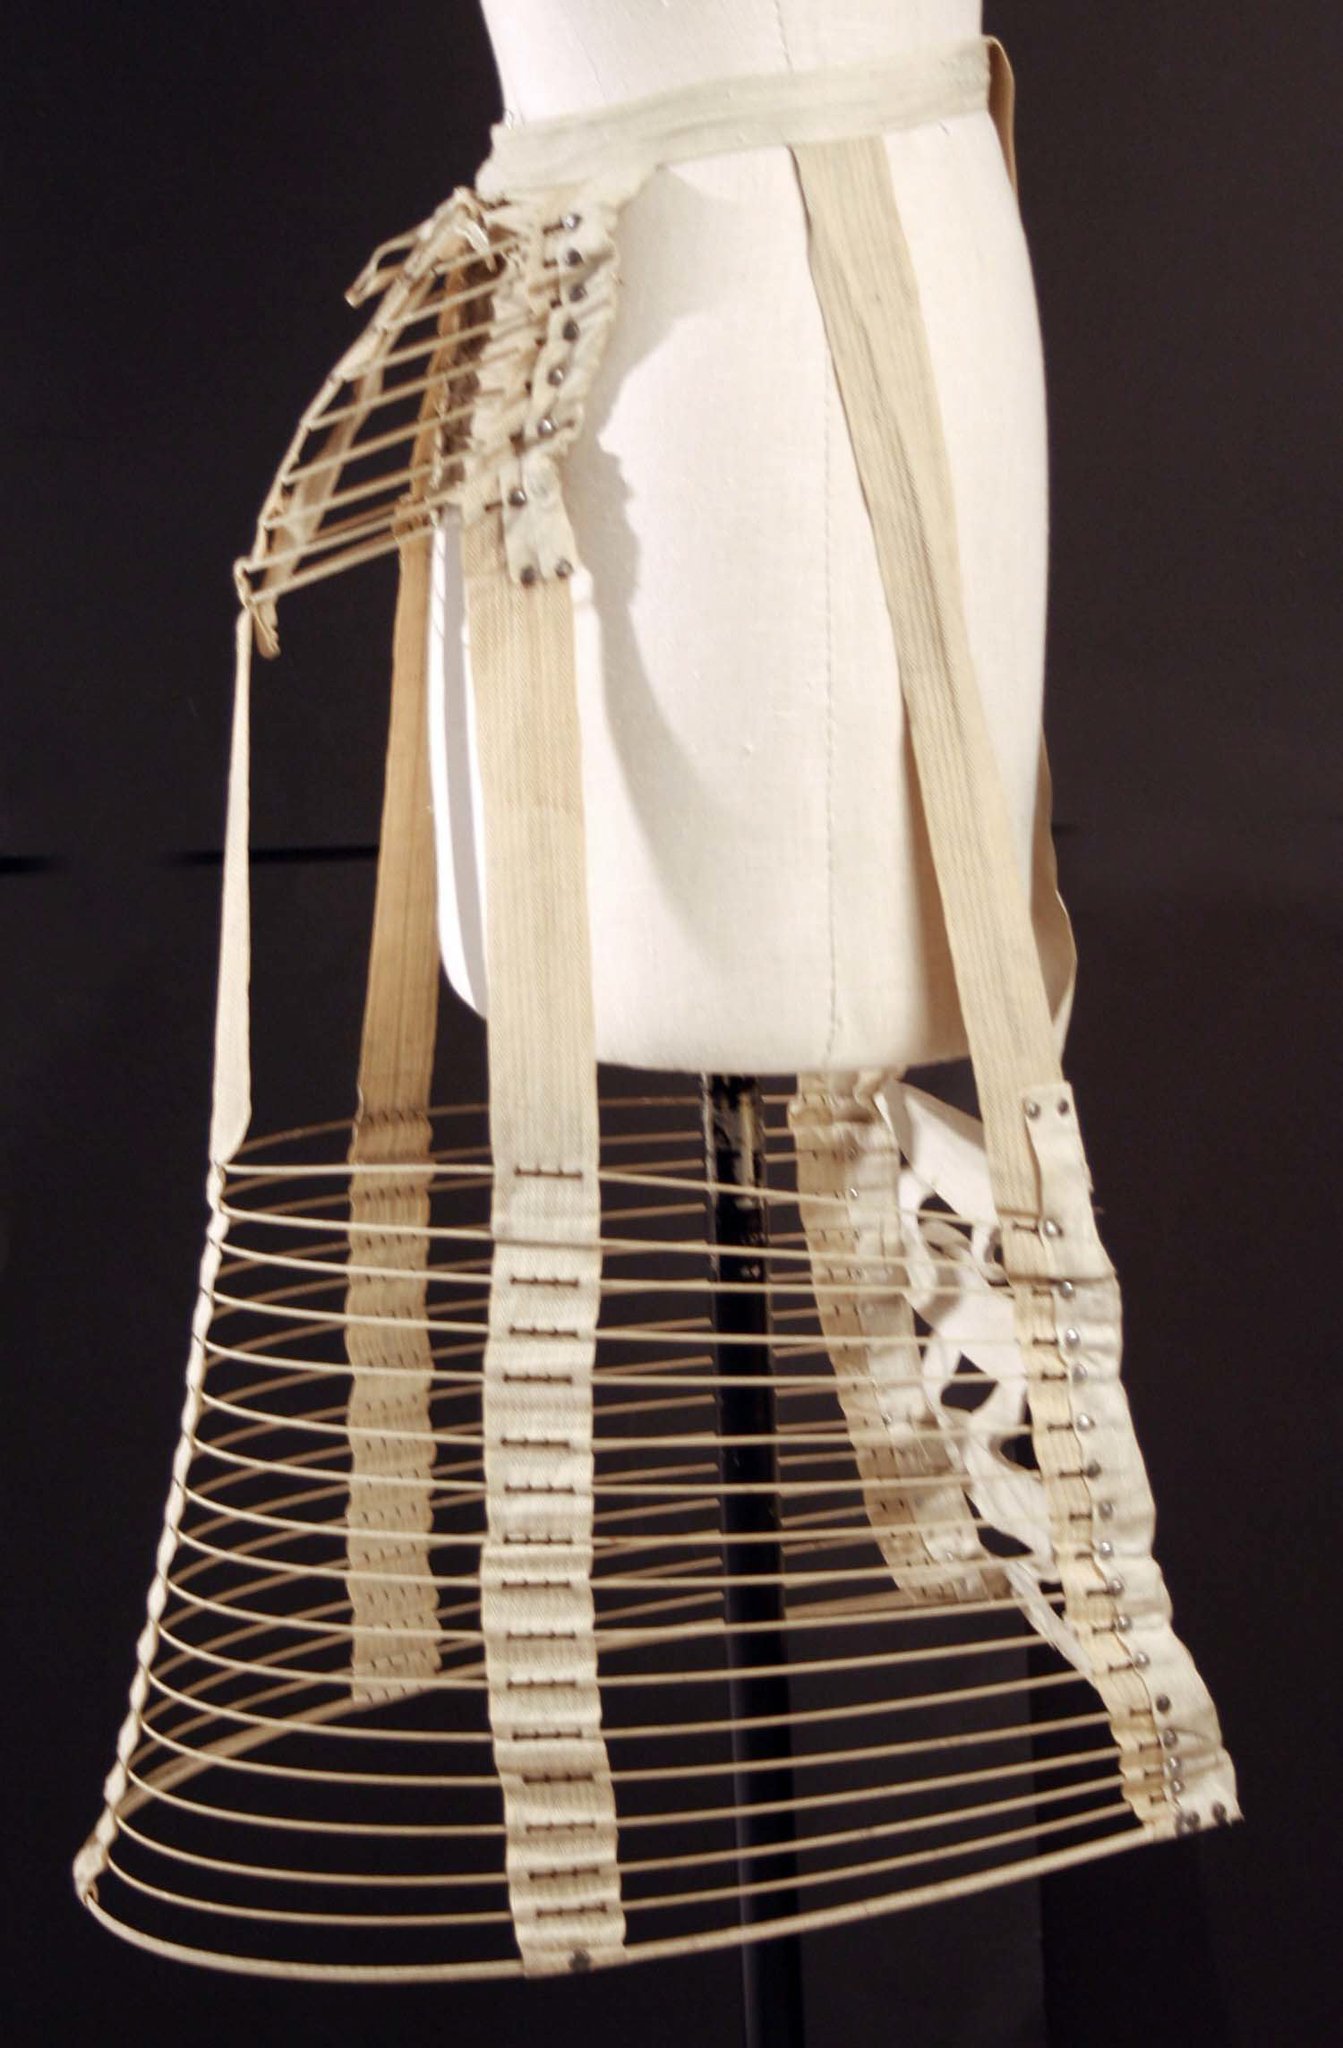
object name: hoop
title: Hoops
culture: american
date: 1880-1889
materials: cotton, metal